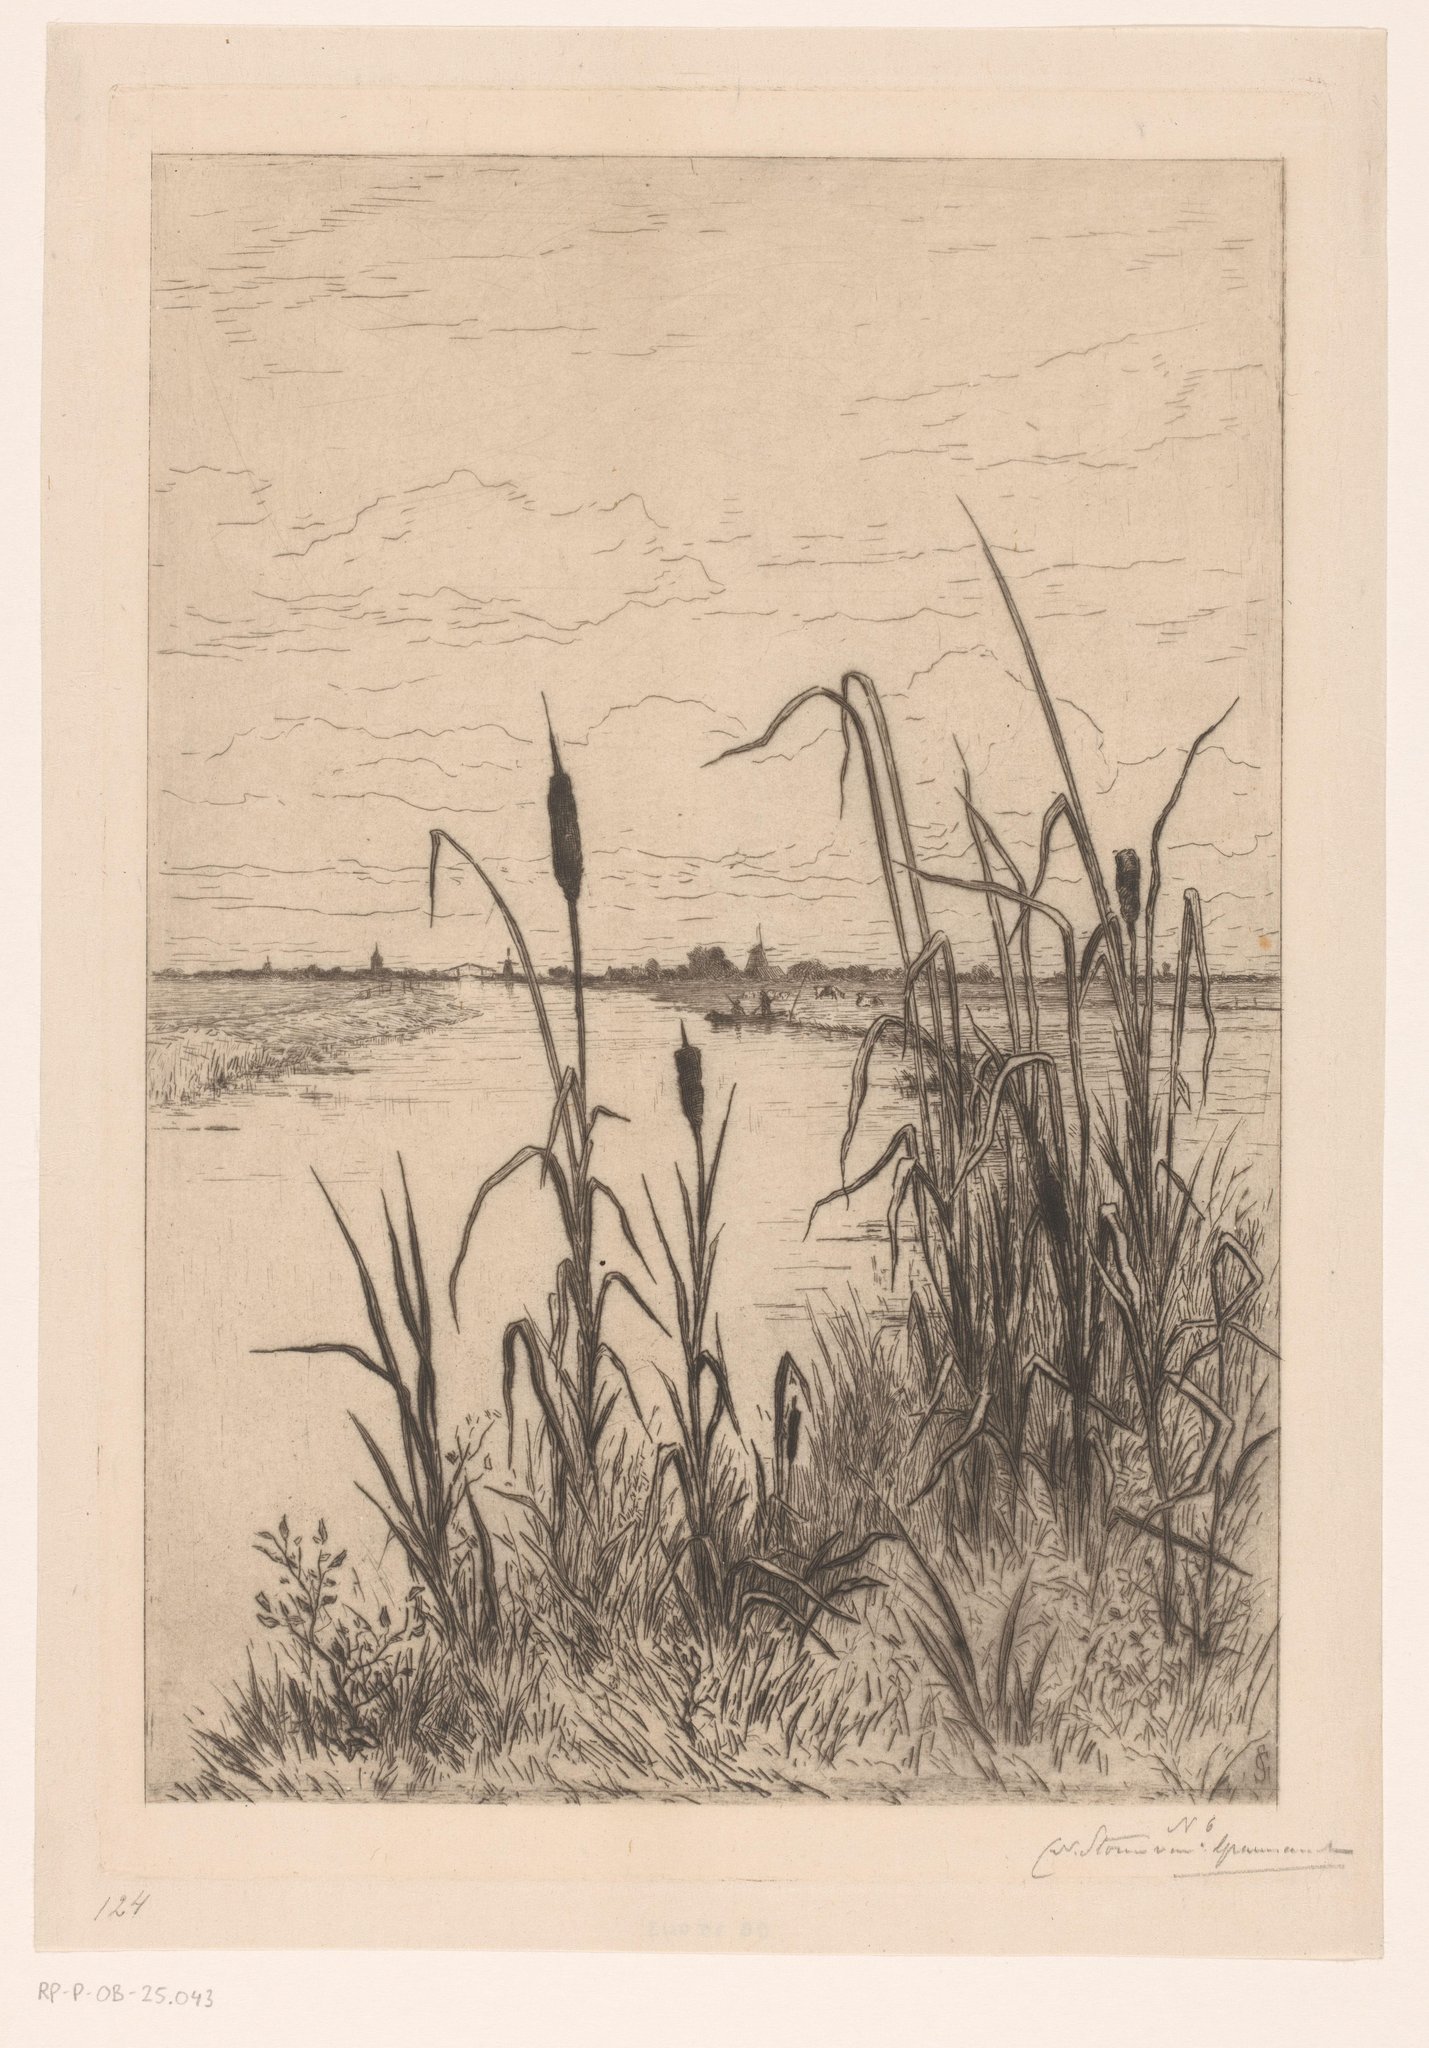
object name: print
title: Canal à Loosdrecht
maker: carel nicolaas storm van s-gravesande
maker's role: draughtsman, print maker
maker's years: 1841-1924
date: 1880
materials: paper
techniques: drypoint, etching, intaglio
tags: plants and herbs: reed, canal (+ landscape with figures, staffage)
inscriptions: number: ‘N 6’, collector's mark: Lugt 2228